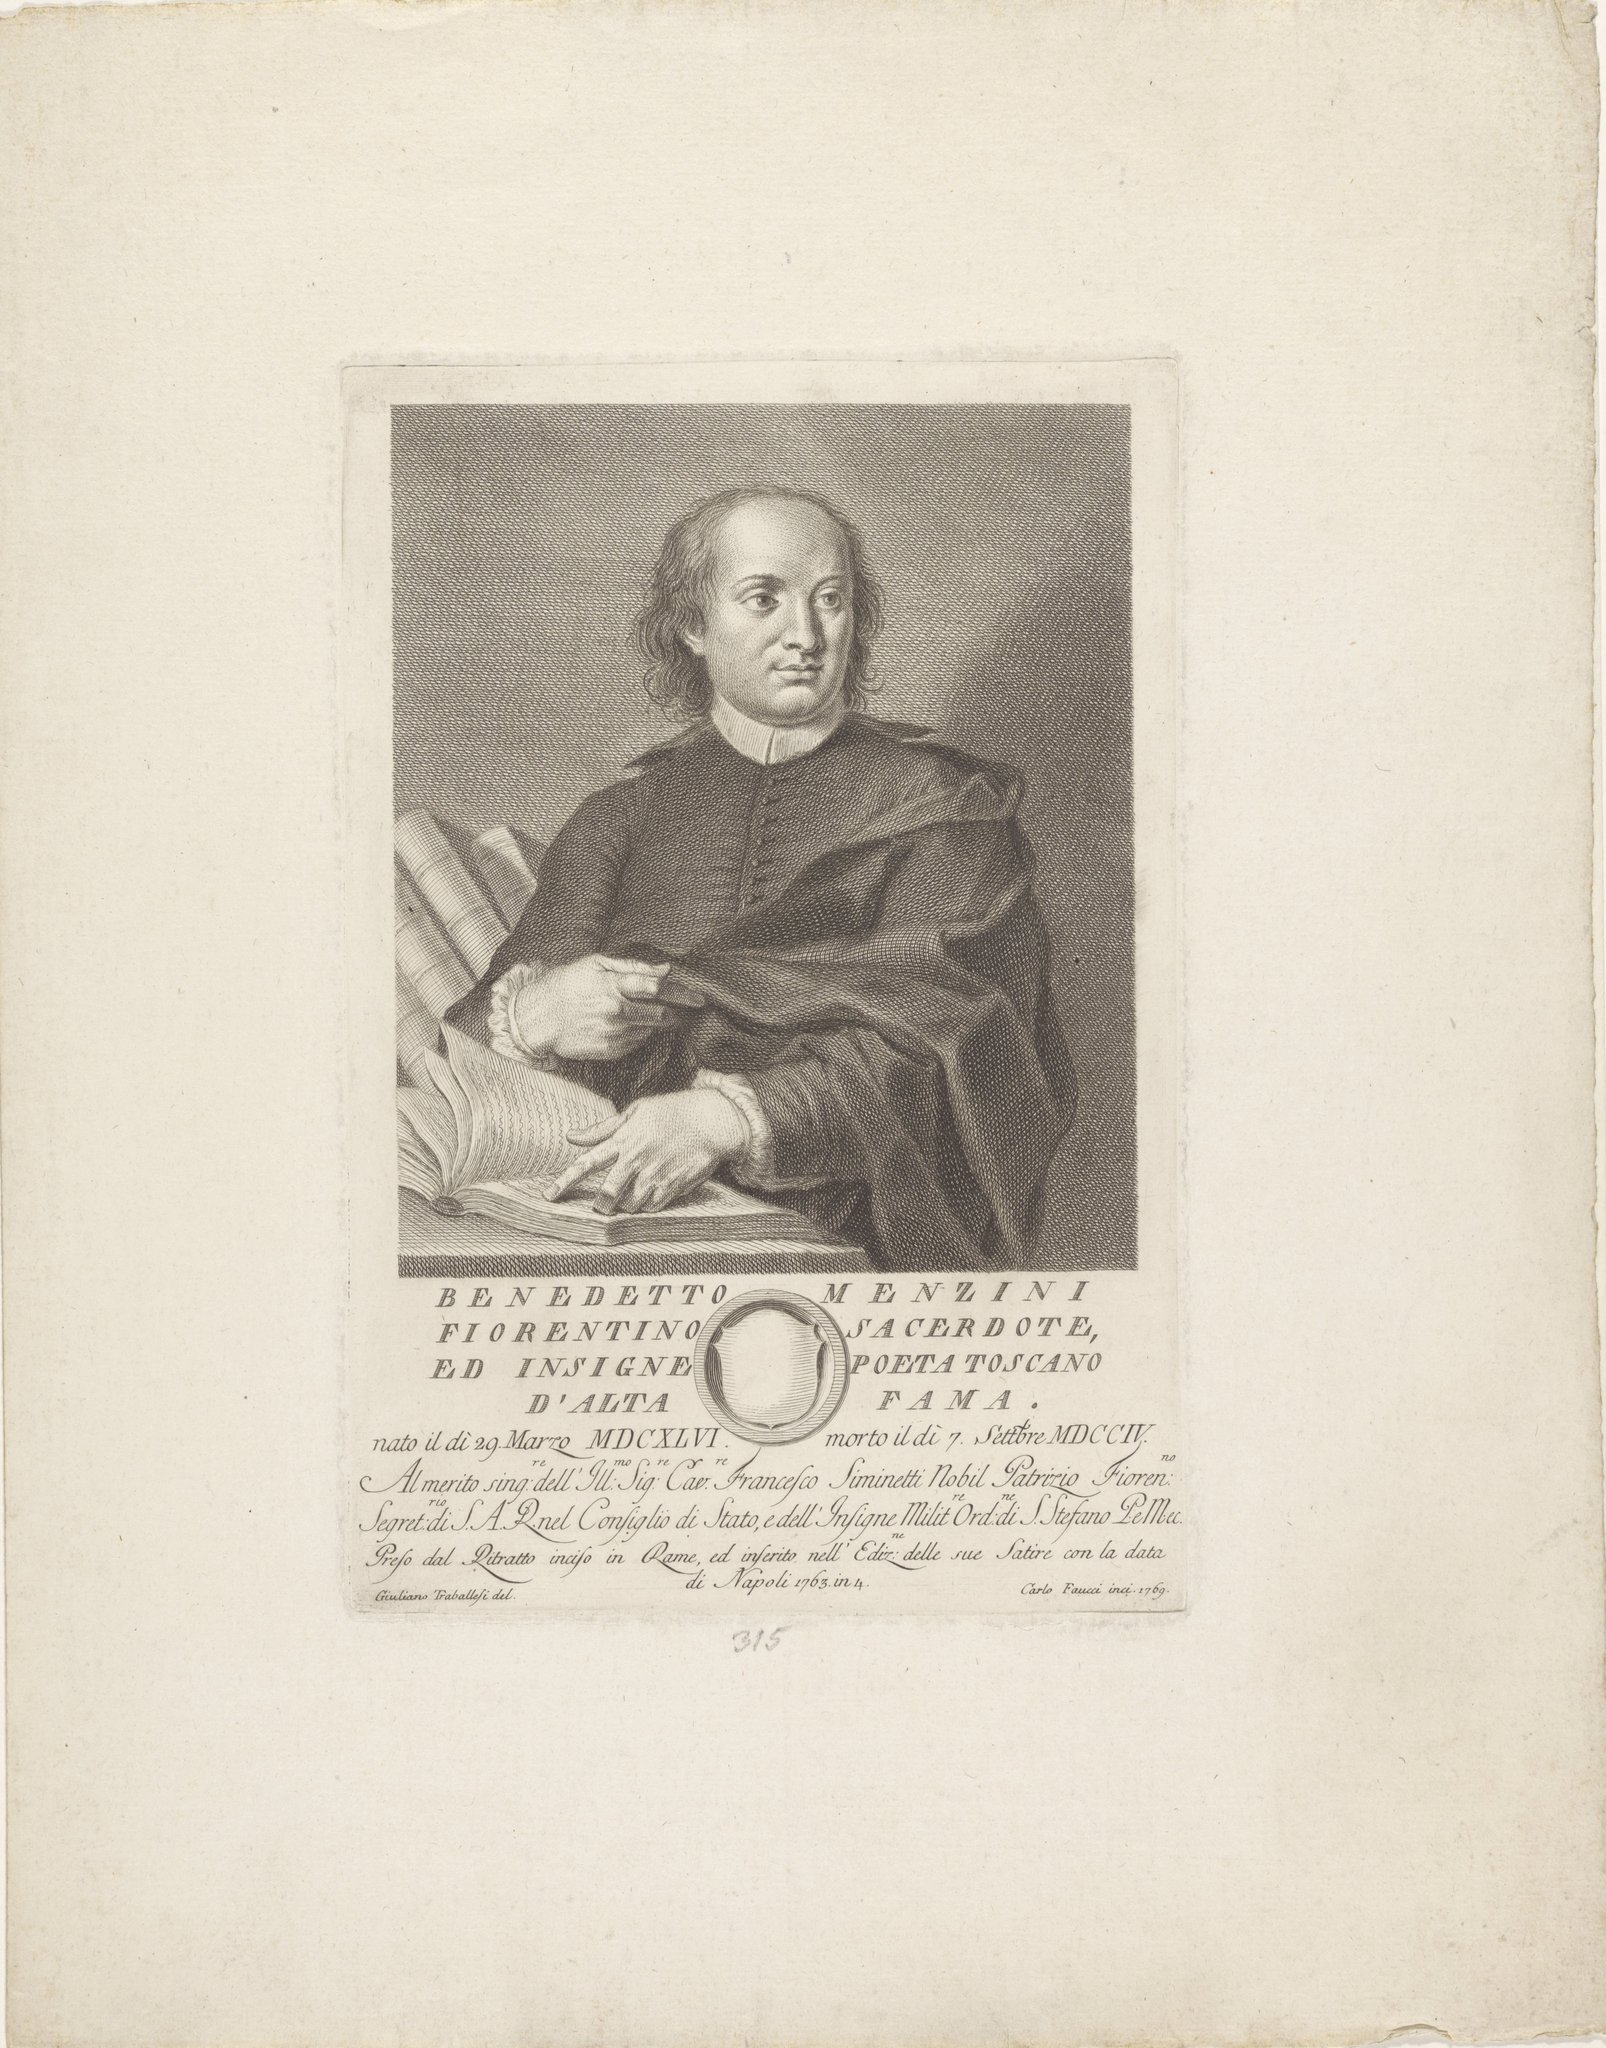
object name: print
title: Portret van priester en dichter Benedetto Menzini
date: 1763-1784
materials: paper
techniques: etching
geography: italy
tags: rome, priest, historical persons, portrait of a writer, writer, poet, author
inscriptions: collector's mark: Lugt 1388, collector's mark: Lugt 2228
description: Deze prent maakt deel uit van een reeks portretprenten van onbekende omvang. De prenten zijn gemaakt door meedere prentmakers, onder wie Francesco Allegrini en Carlo en Raimondo Faucci.